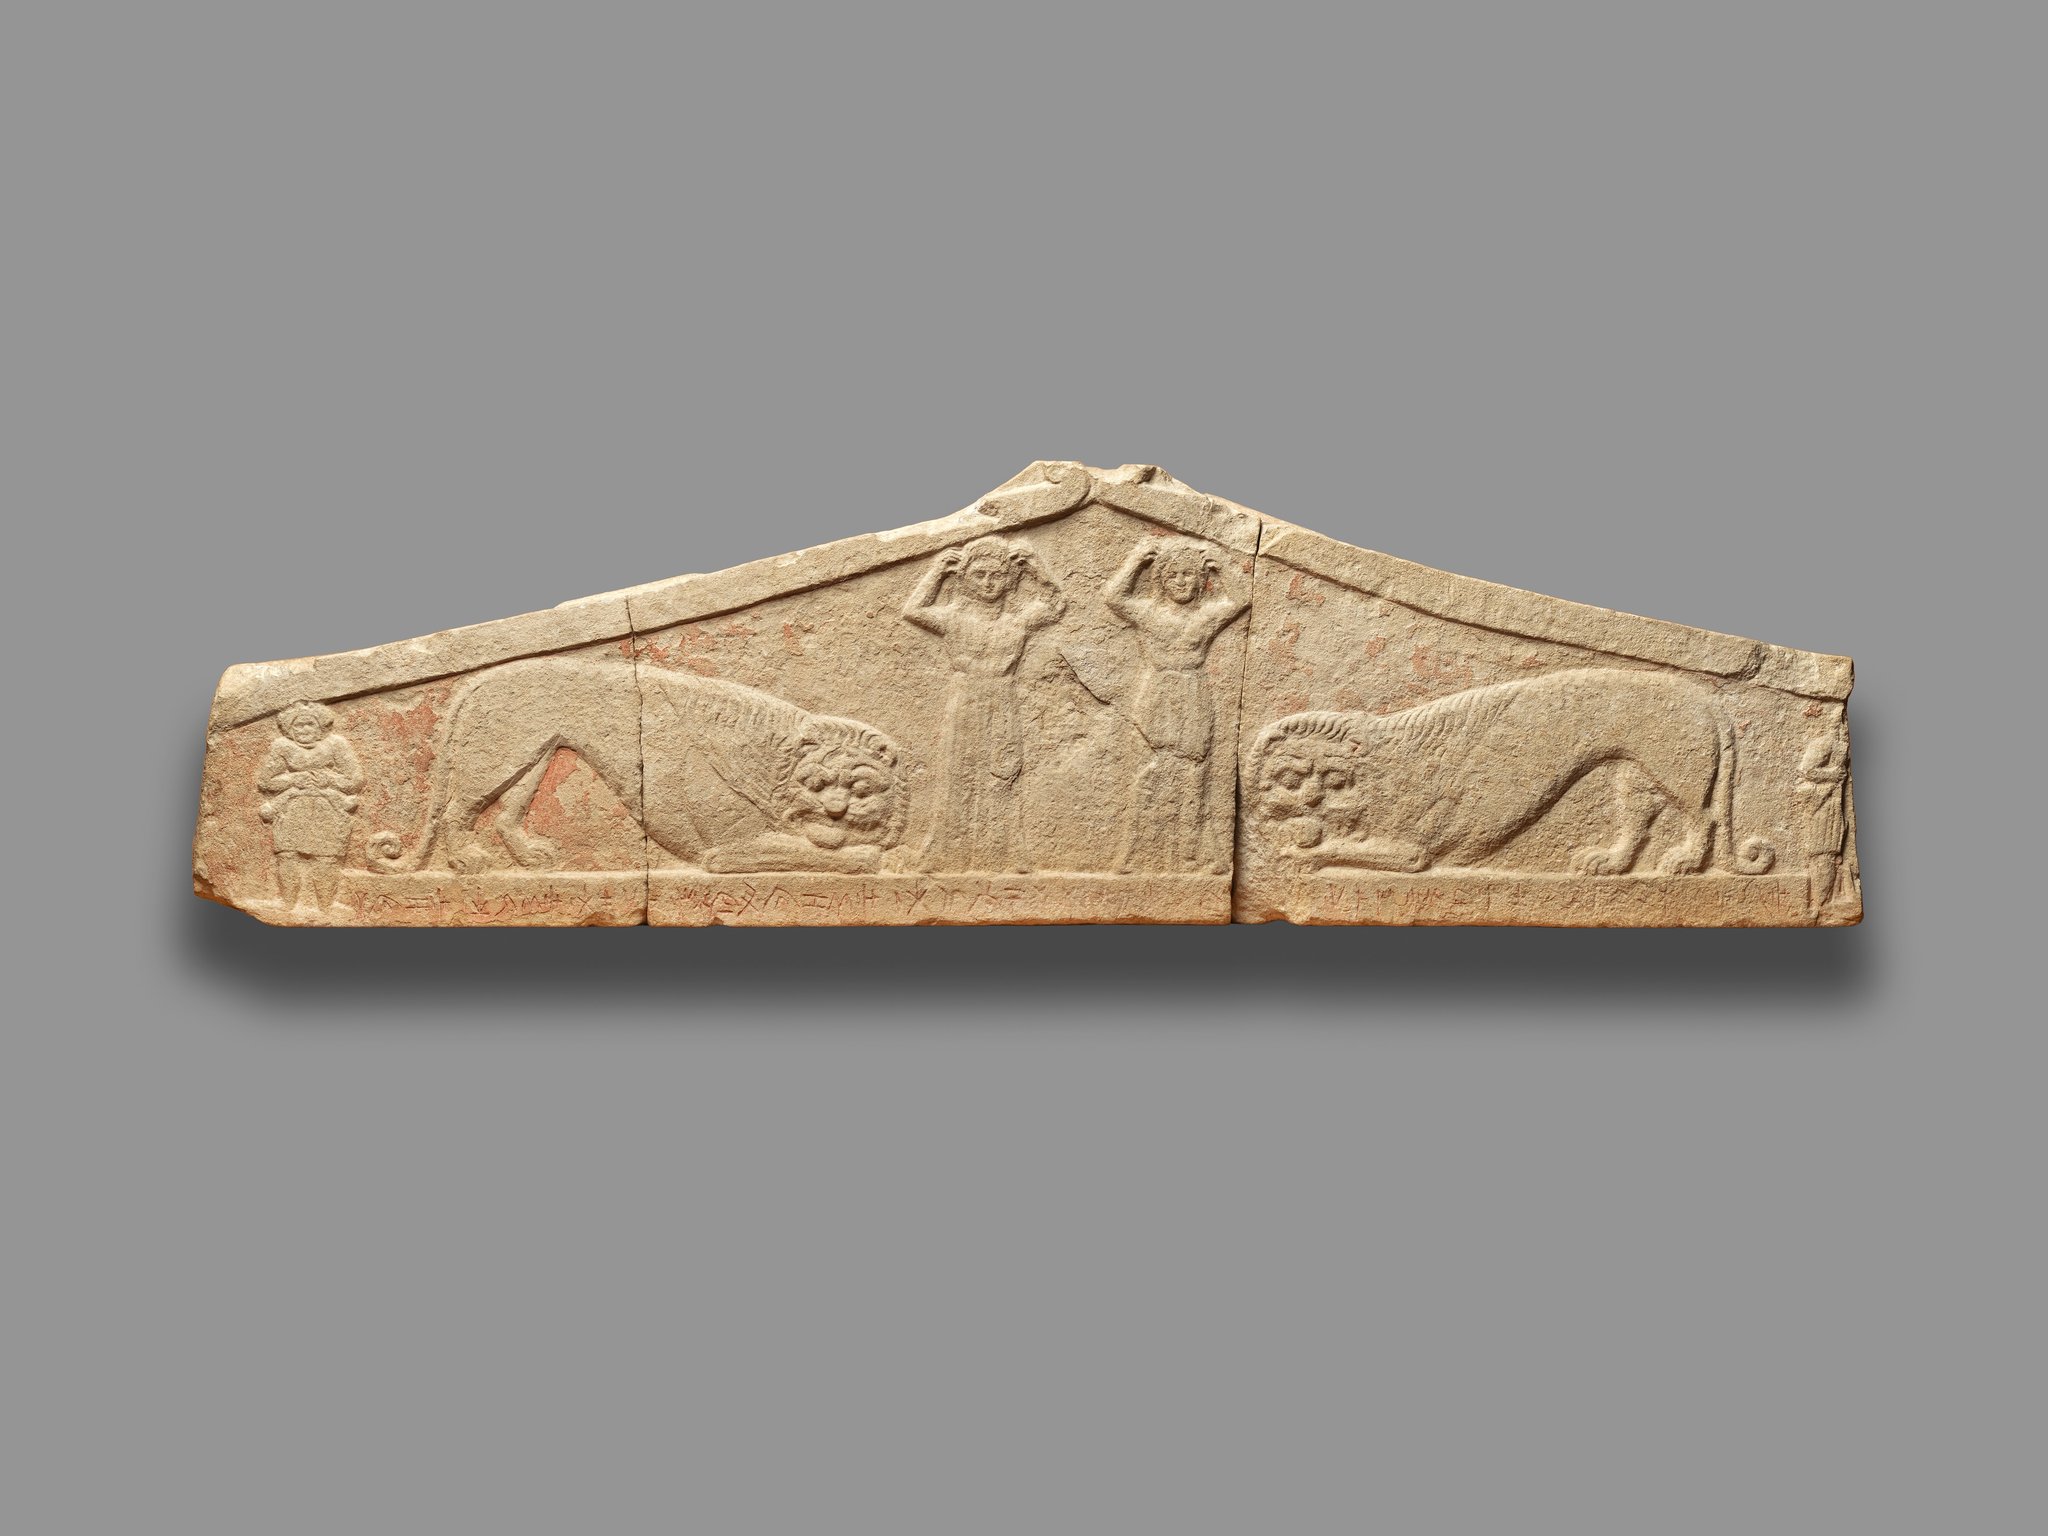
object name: grave stele pediment of aristokretes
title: Limestone pediment from a funerary stele (shaft)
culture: cypriot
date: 300-101 BCE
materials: limestone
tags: men,women,lions